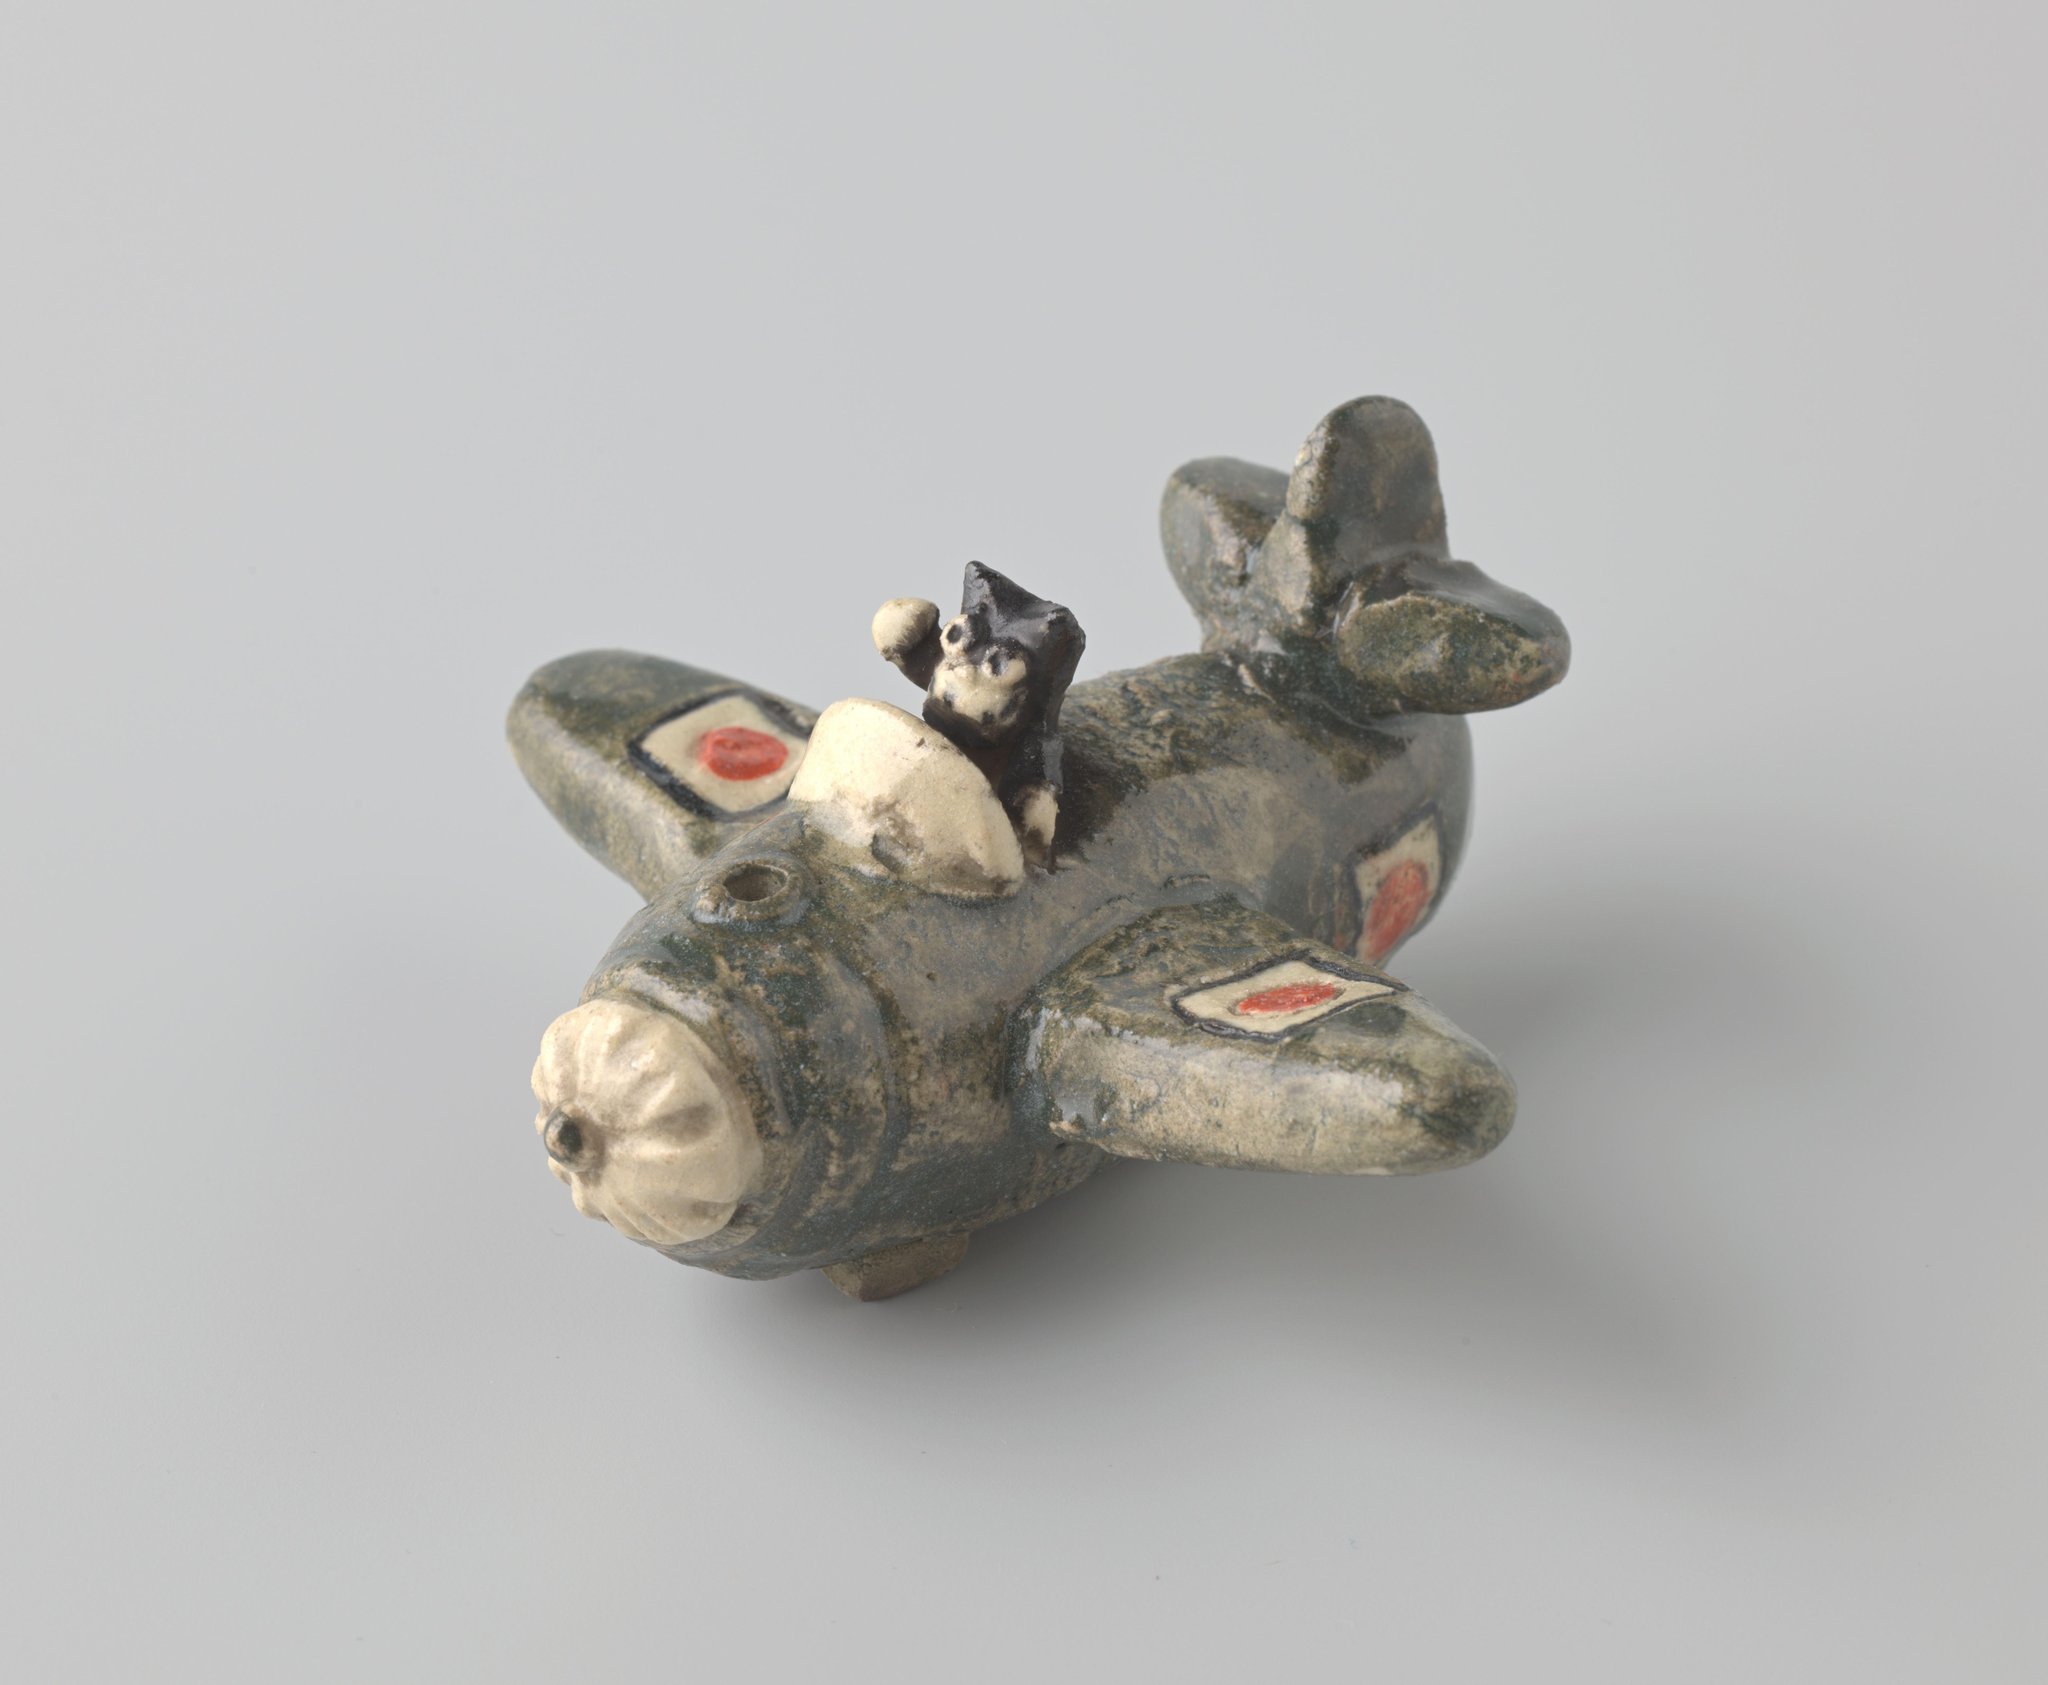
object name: water dropper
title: Waterdropper in the shape of an airplane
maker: Anonymous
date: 1931-1941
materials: stoneware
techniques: vitrification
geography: japan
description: Een steengoed waterdruppelaar (水滴, suiteki) in de vorm van een vliegtuig, bestuurd door de stripfiguur Norakuro のらくろ. Versierd in groen glazuur met details in rood, zwart en wit, met de hond Norakuro in zwart en wit en Japanse vlaggen op de vleugels en zijkanten van het vliegtuig.